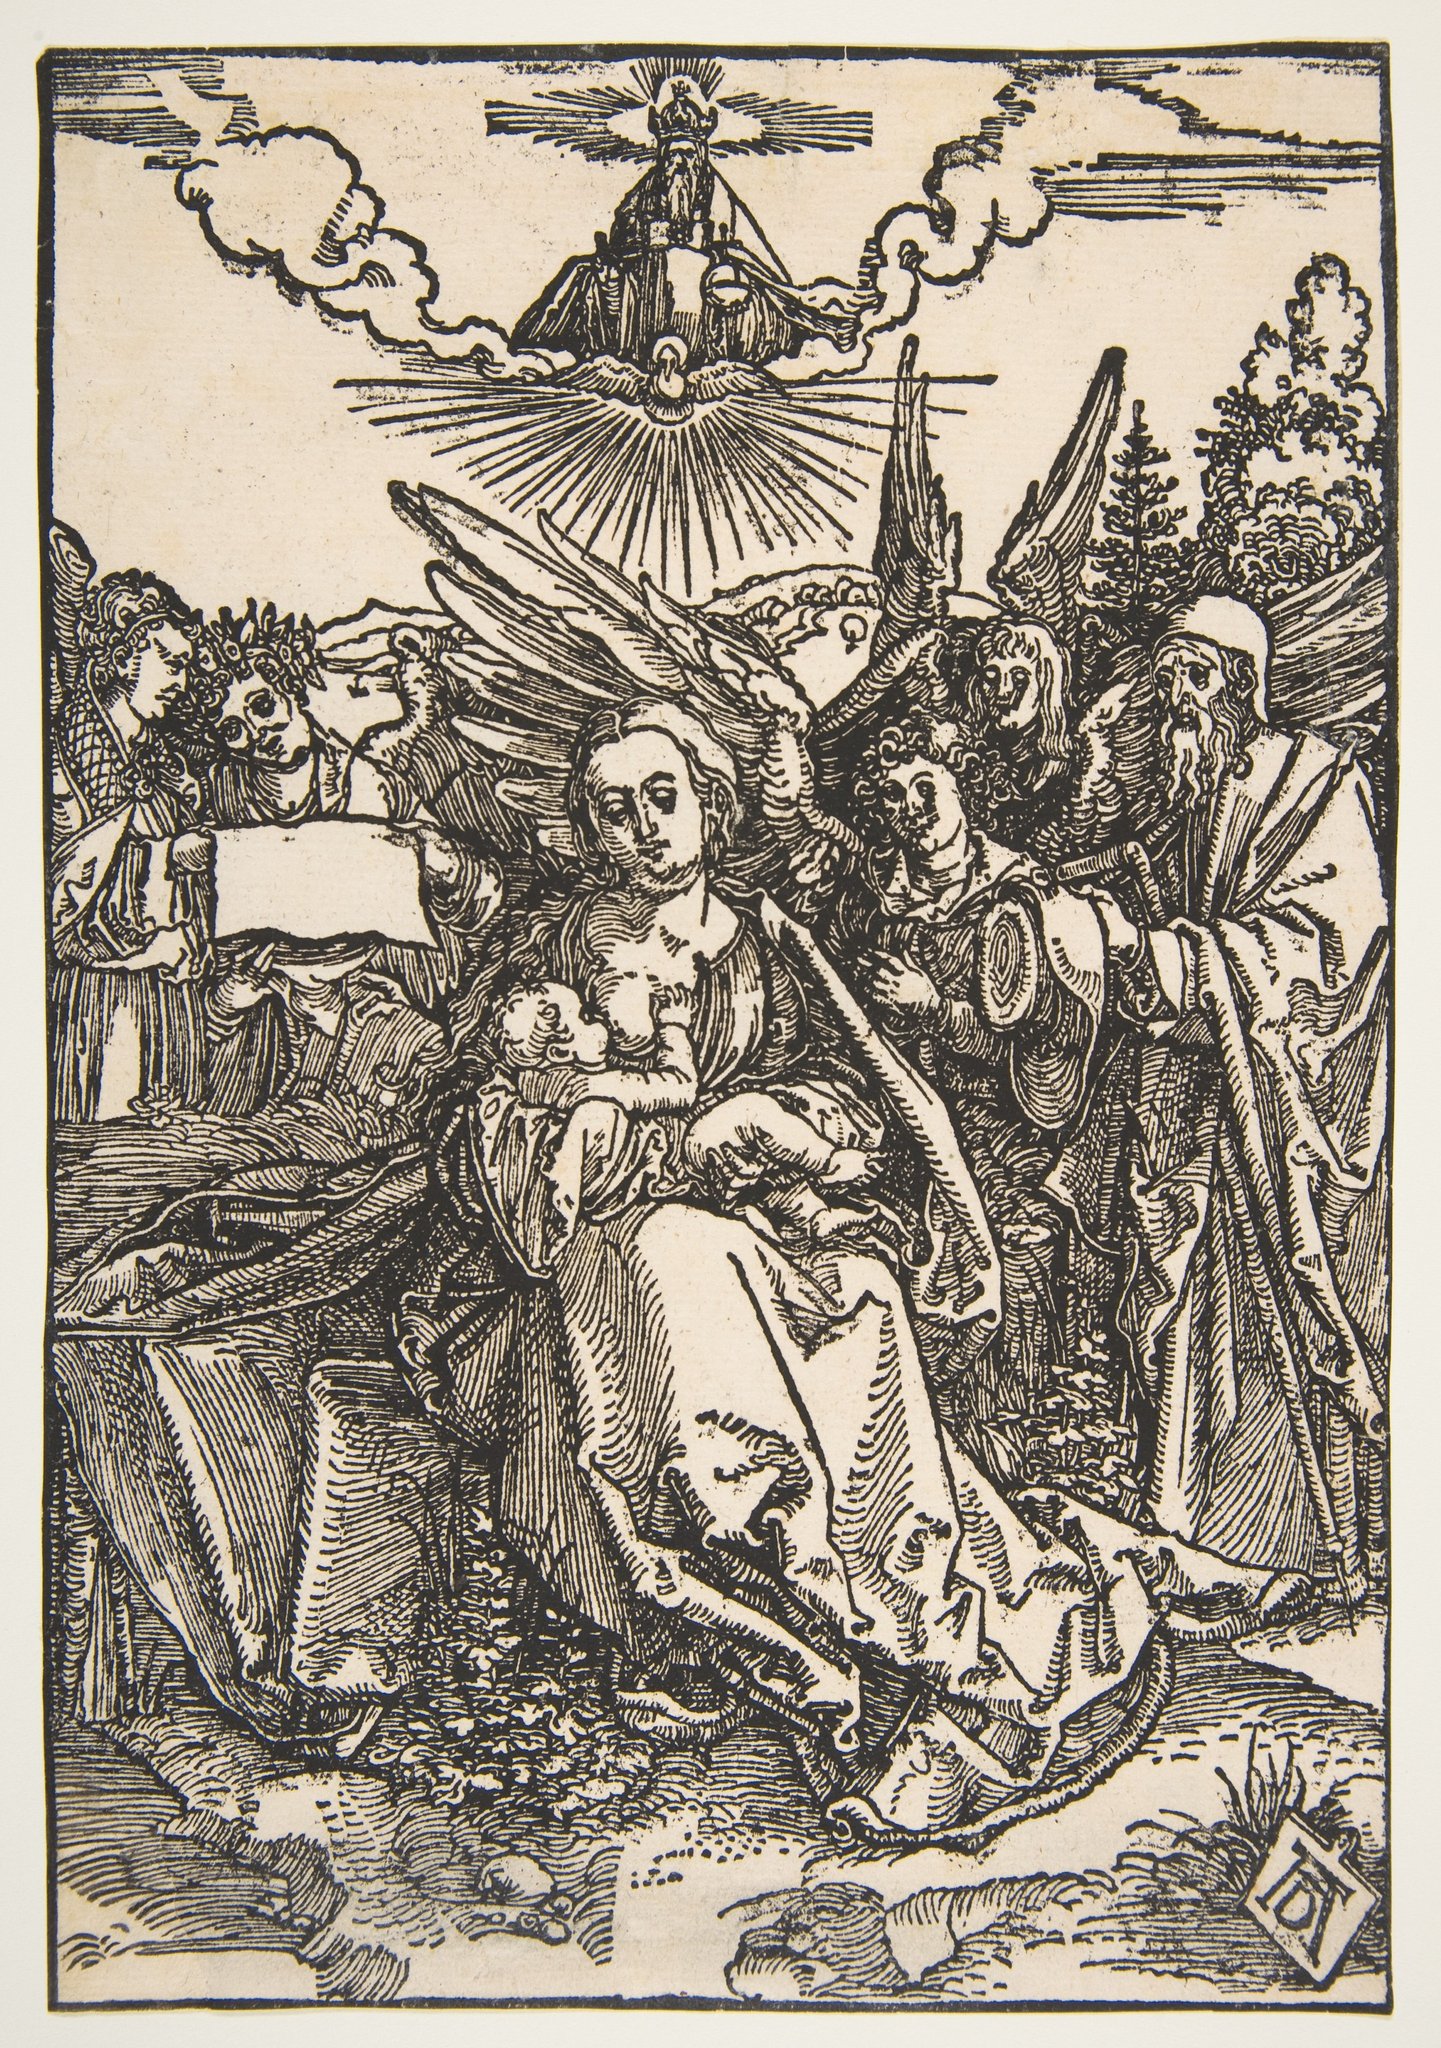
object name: print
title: The Holy Family with Five Angels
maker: albrecht dürer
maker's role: artist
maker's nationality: german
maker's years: 1471-1528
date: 1503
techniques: woodcut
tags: angels,christ,holy family,saint joseph,virgin mary